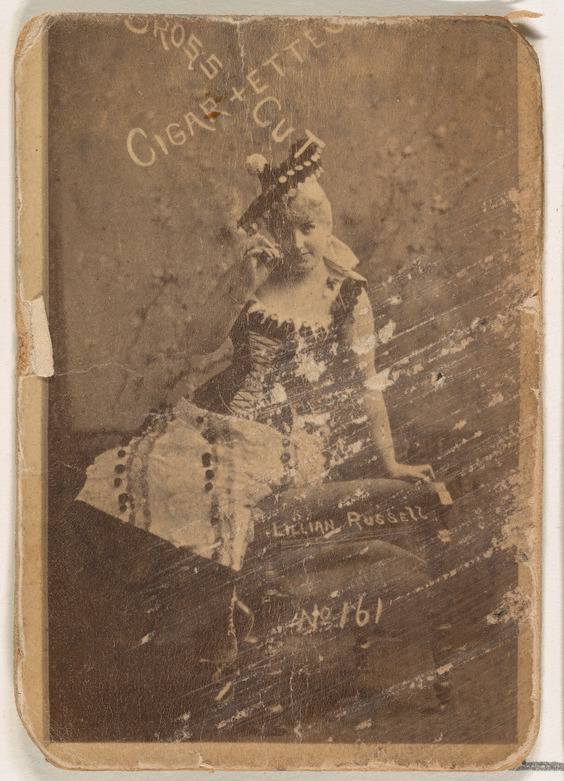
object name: print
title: Card Number 161, Lillian Russell, from the Actors and Actresses series (N145-1) issued by Duke Sons & Co. to promote Cross Cut Cigarettes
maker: w. duke, sons & co.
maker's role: publisher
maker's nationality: american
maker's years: 1870-1920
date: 1880-1889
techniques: albumen silver print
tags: portraits,women,actresses